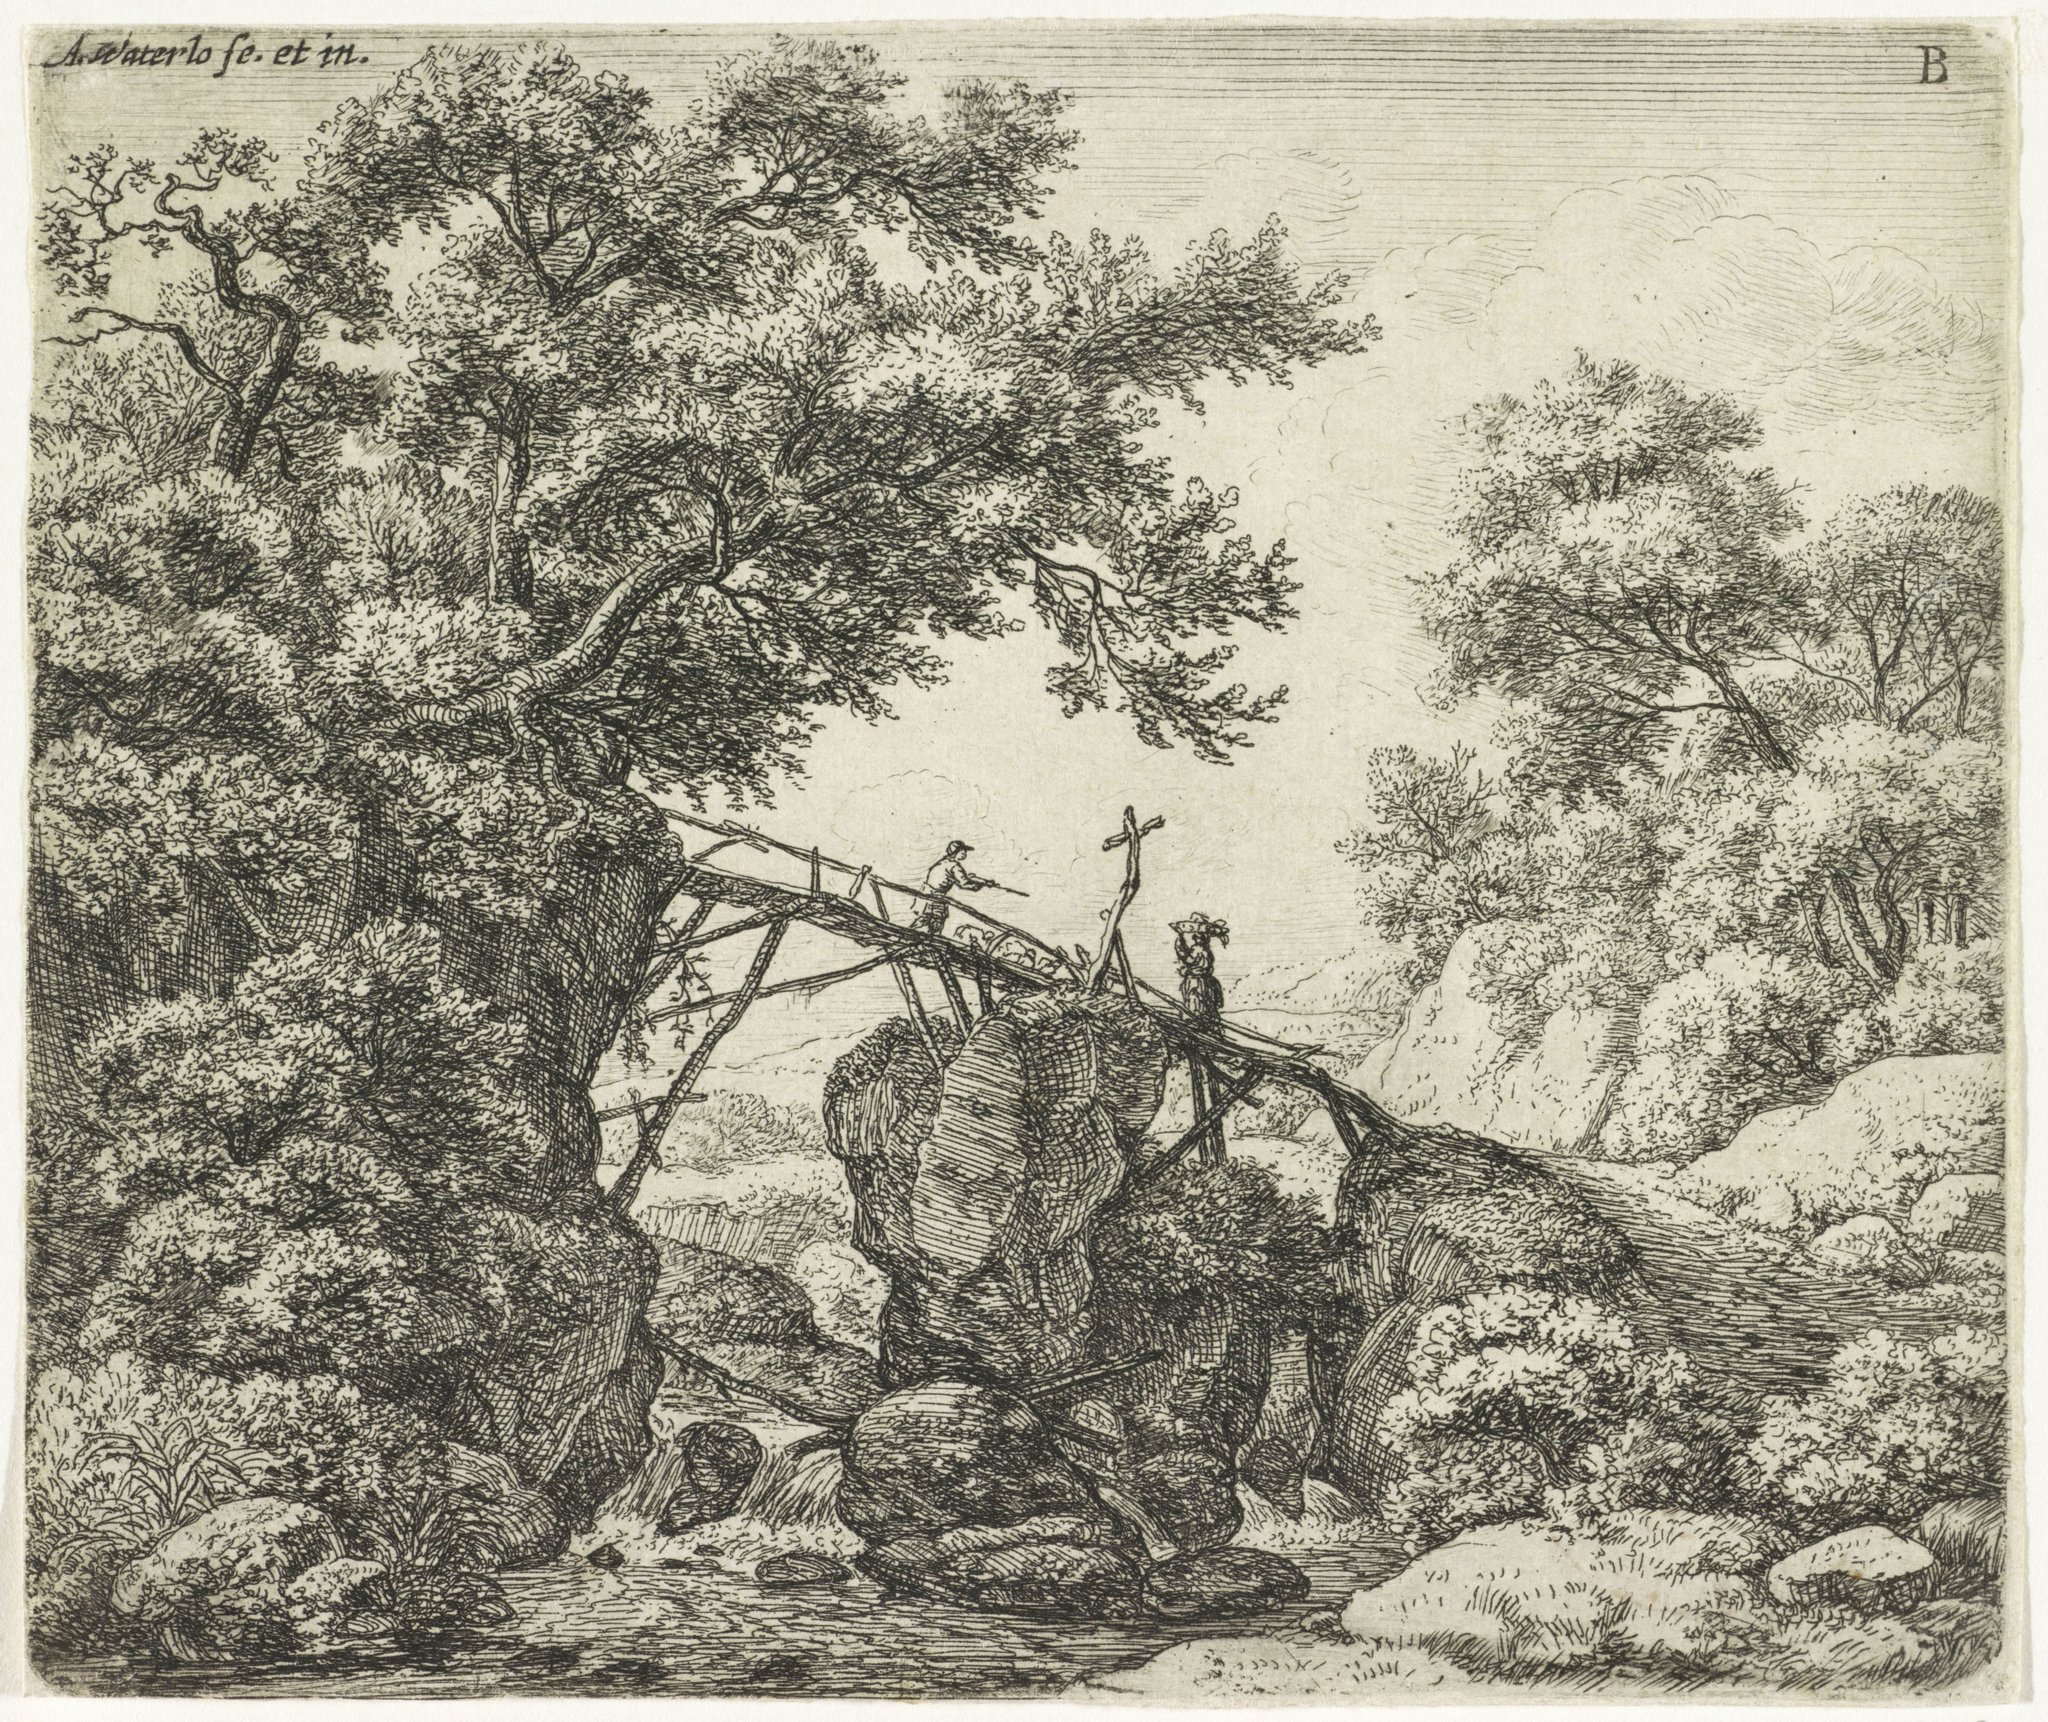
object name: print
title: Herder op een hellende brug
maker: anthonie waterloo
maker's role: draughtsman, painter, print maker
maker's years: 1609-1690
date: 1630-1663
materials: paper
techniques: etching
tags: herding, herdsman, herdswoman, shepherd, shepherdess, cowherd, etc., waterfall, rock-formations, bridge, 'en route', traveller under way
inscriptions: collector's mark: Lugt 240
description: Over een beek met een waterval loopt een smalle, hellende houten brug. Over de brug loopt een herder met zijn kudde en een vrouw met goederen op haar hoofd. Rechts loopt een pad en rechtsboven is de letter B te zien.